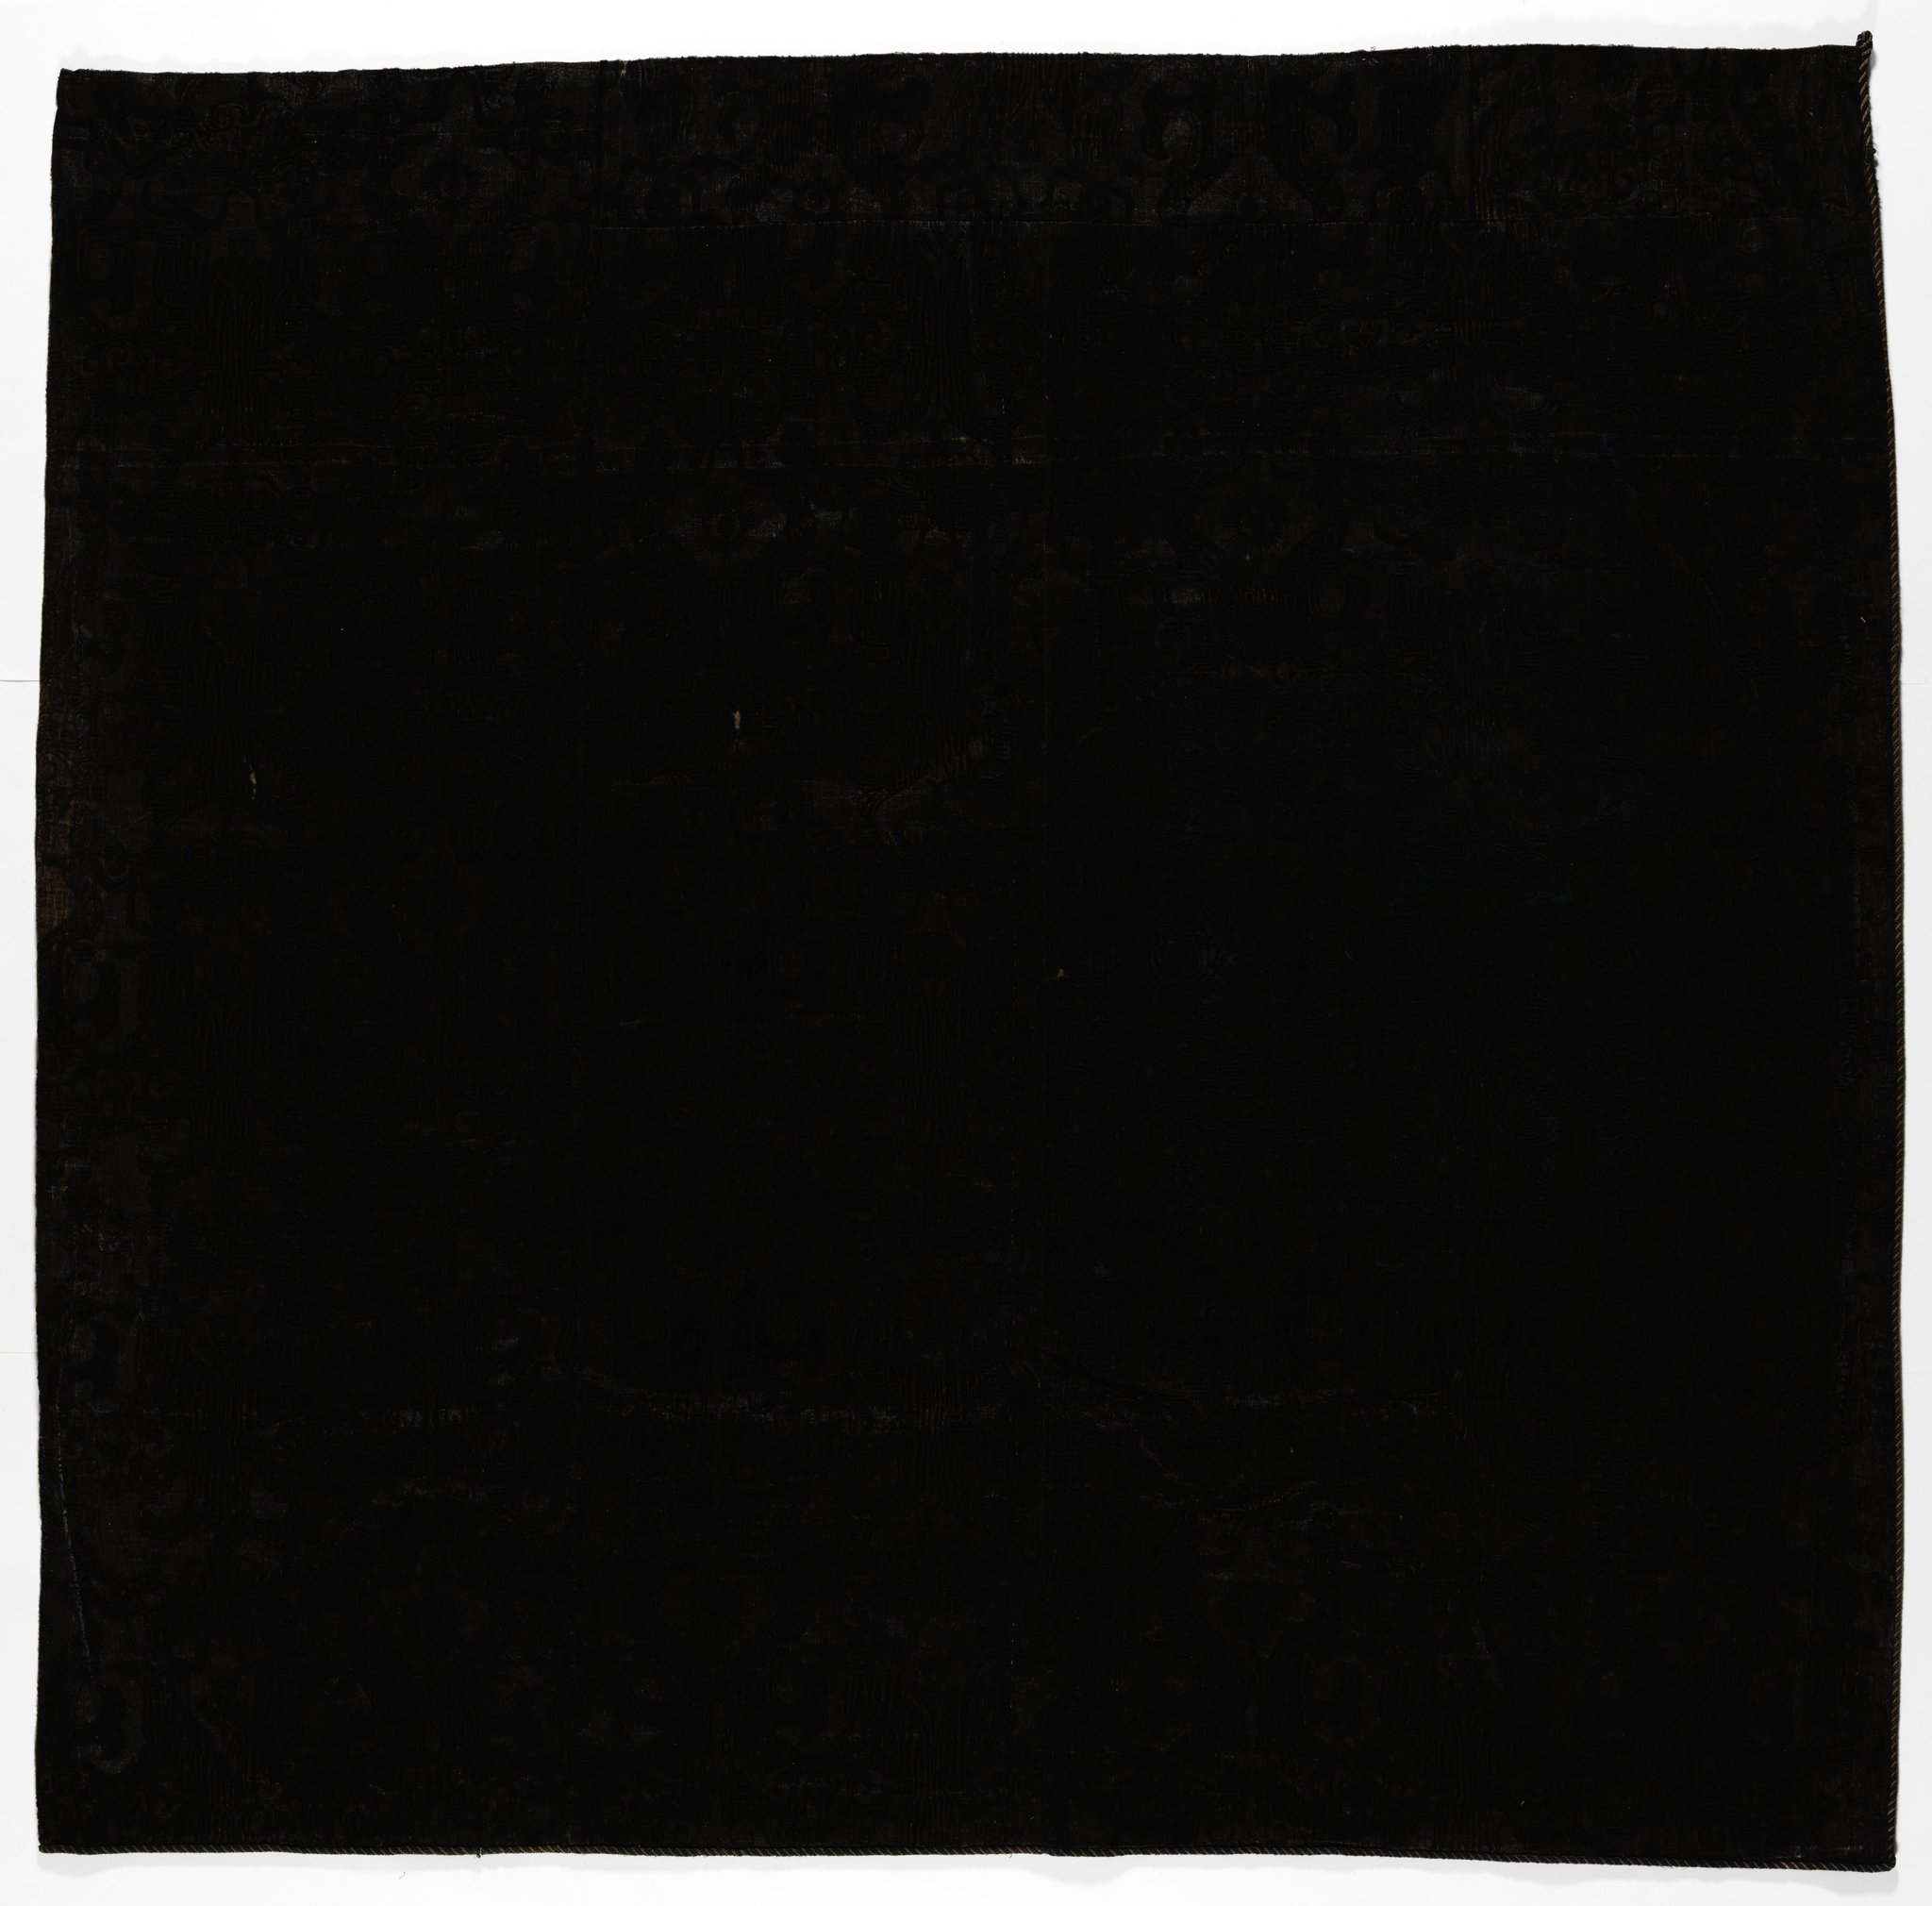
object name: curtain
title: Gordijn van ingeschoren trijp met dessin "Zeenymphen", donkerblauw op goud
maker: carel adolph lion cachet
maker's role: draughtsman, print maker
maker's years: 1864-1945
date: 1920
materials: cotton, gold thread, textile, hair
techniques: relief velvet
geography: netherlands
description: Gordijn van ingeschoren trijp met dessin "Zeenymphen" in donkerblauw op goud. Dit dessin wordt ook wel "Zeemeermin" genoemd. Het patroon bestaat uit horizontale rijen van paren zeemeerminnen, afgebeeld in profil en naar elkaar toegekeerd. Tussen de rijen zeemeerminnen of zeenimfen zijn geabstraheerde golven te zien. Gordijn is langs de randen versierd met koord waarin metaaldraad verwerkt is. Gevoerd.